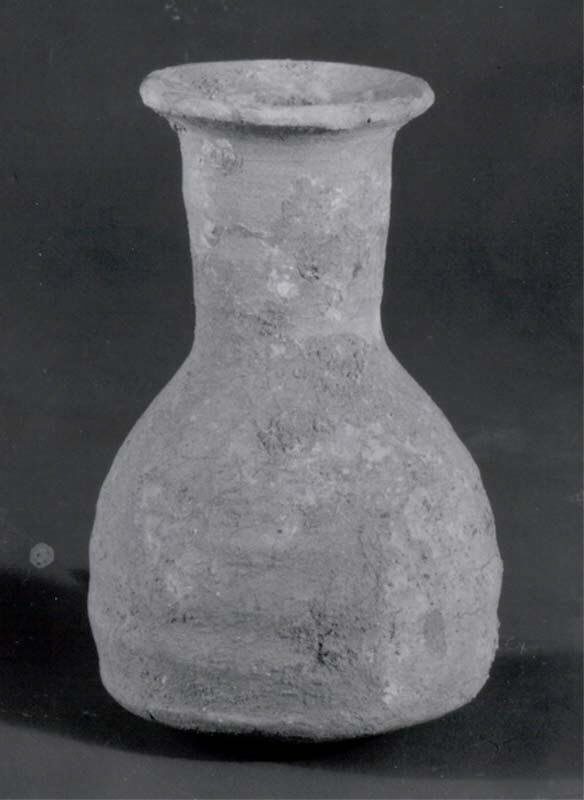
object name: vessel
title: Unguentarium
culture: nabataean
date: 1-100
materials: ceramic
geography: levant